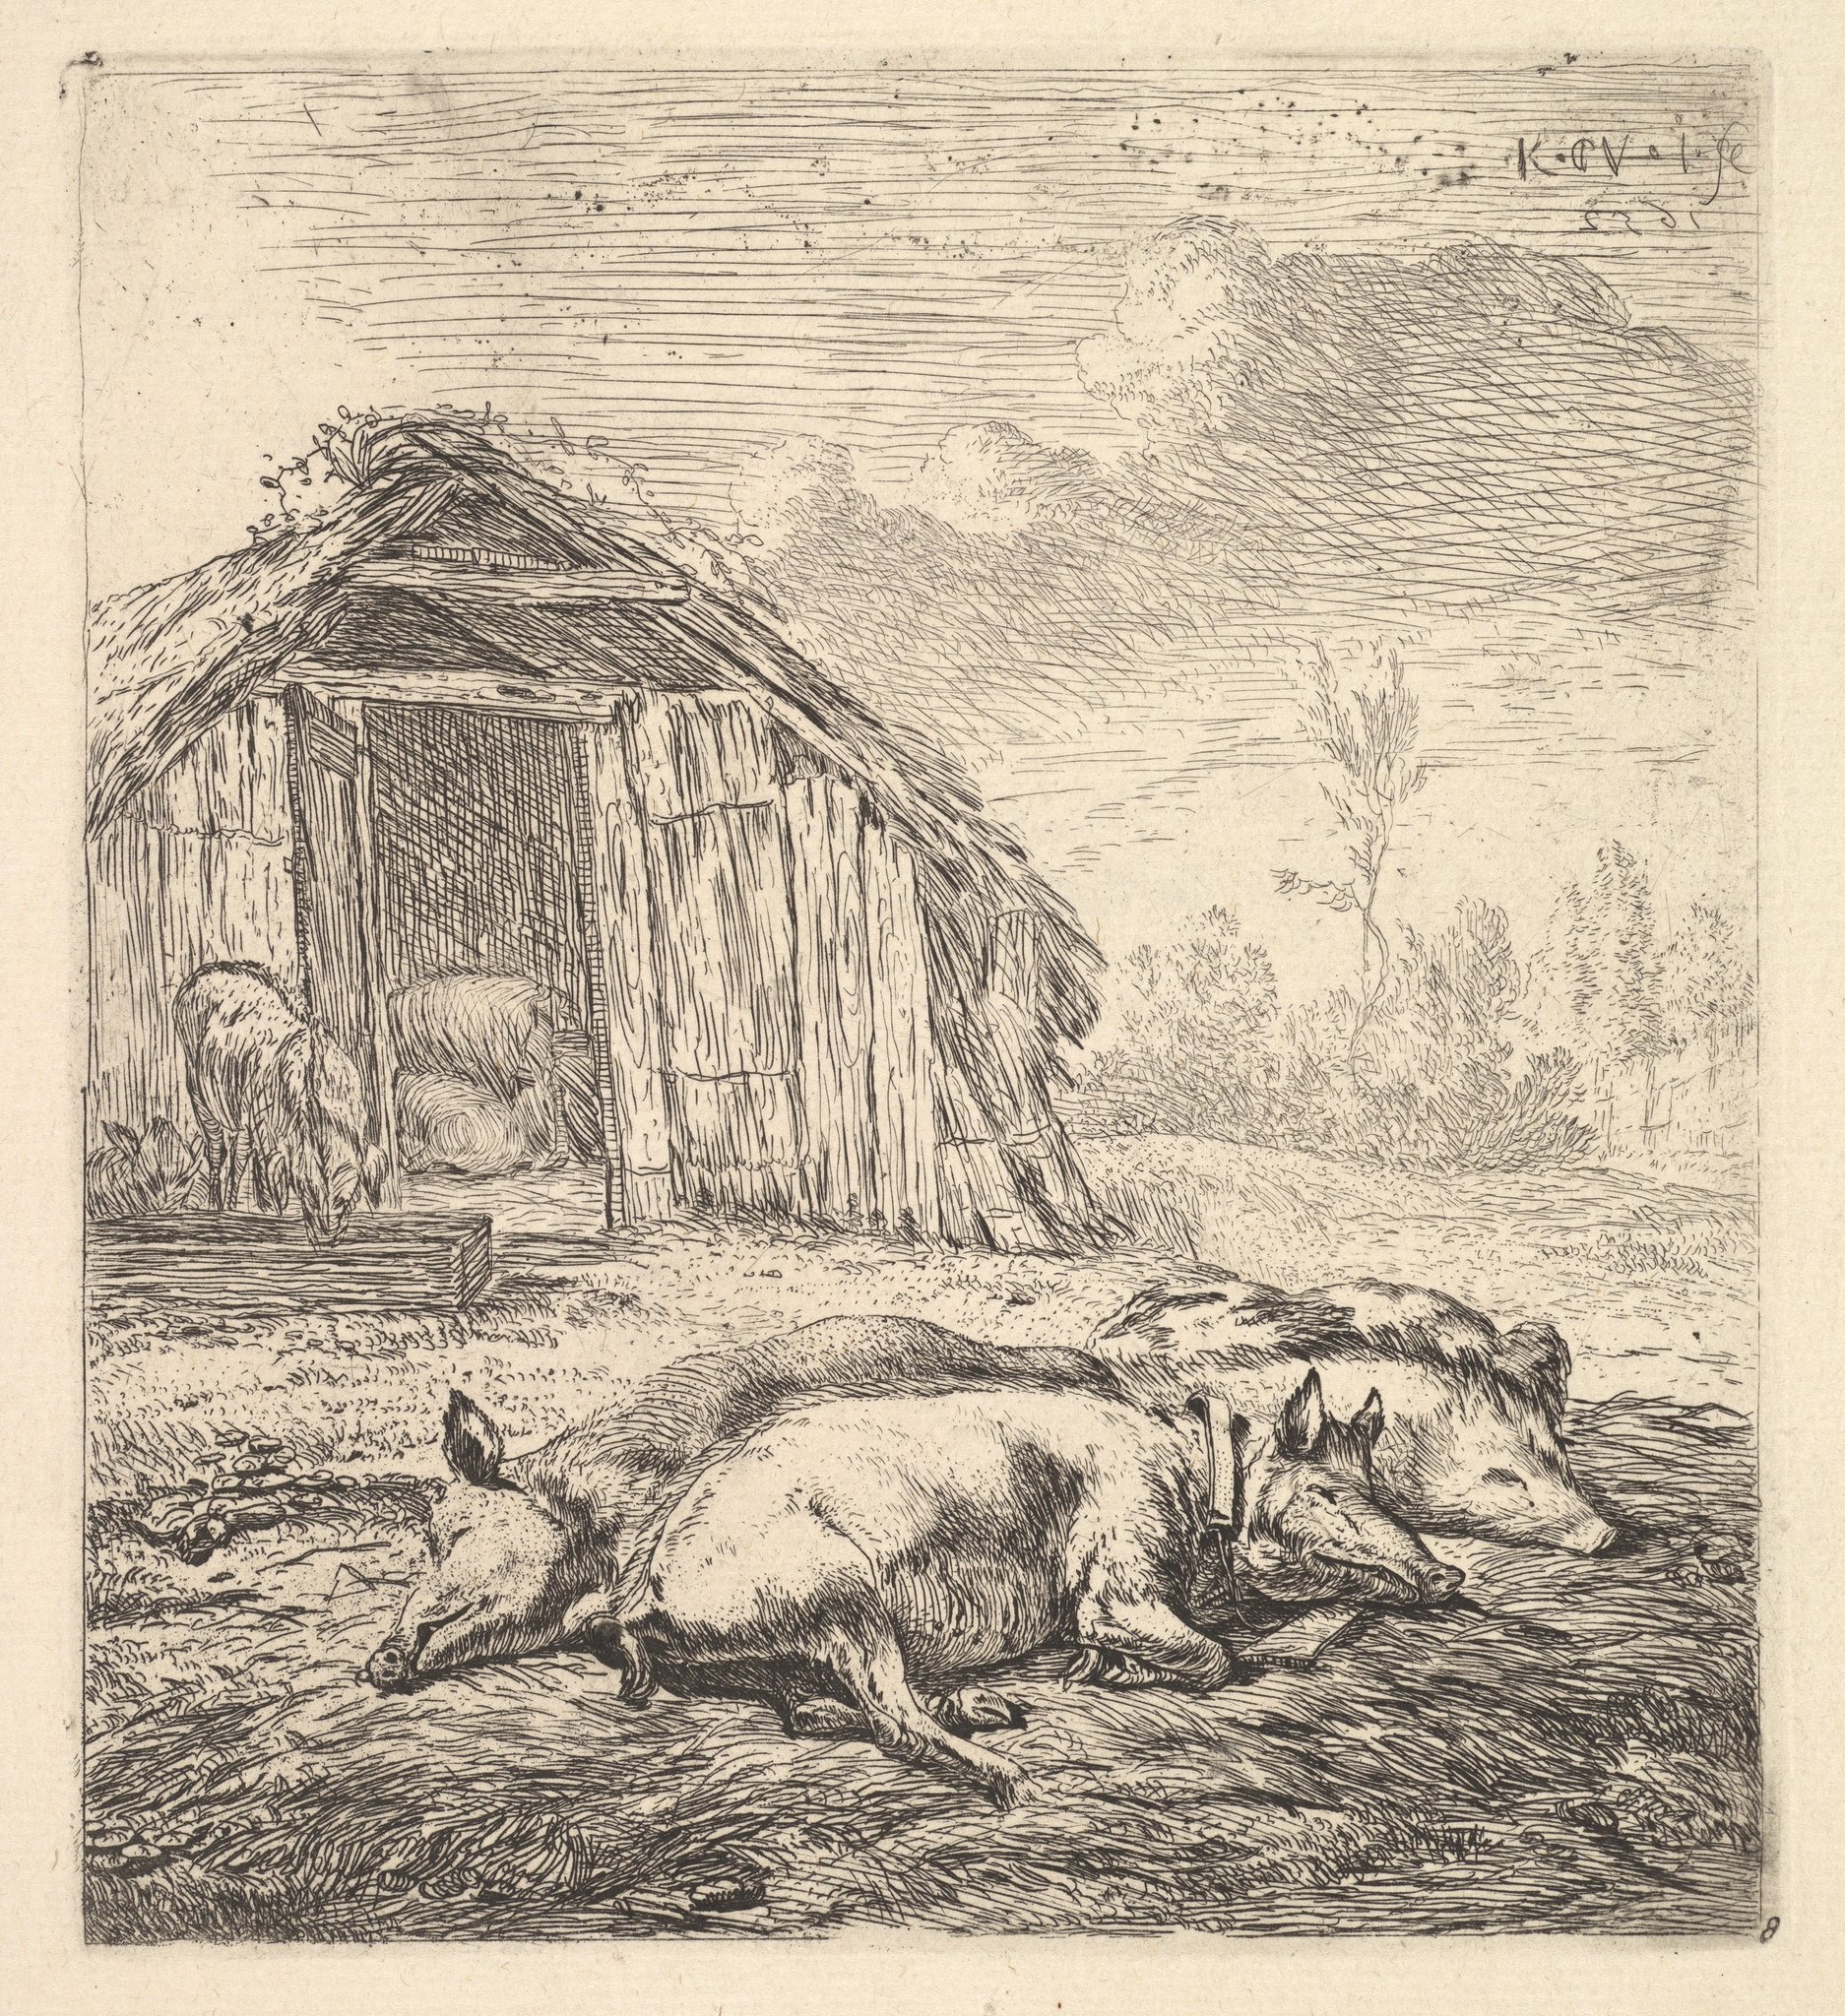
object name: print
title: Three pigs lying on their sides, a pigsty and trough beyond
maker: karel dujardin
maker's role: artist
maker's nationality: dutch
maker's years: 1622-1678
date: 1652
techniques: etching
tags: pigs